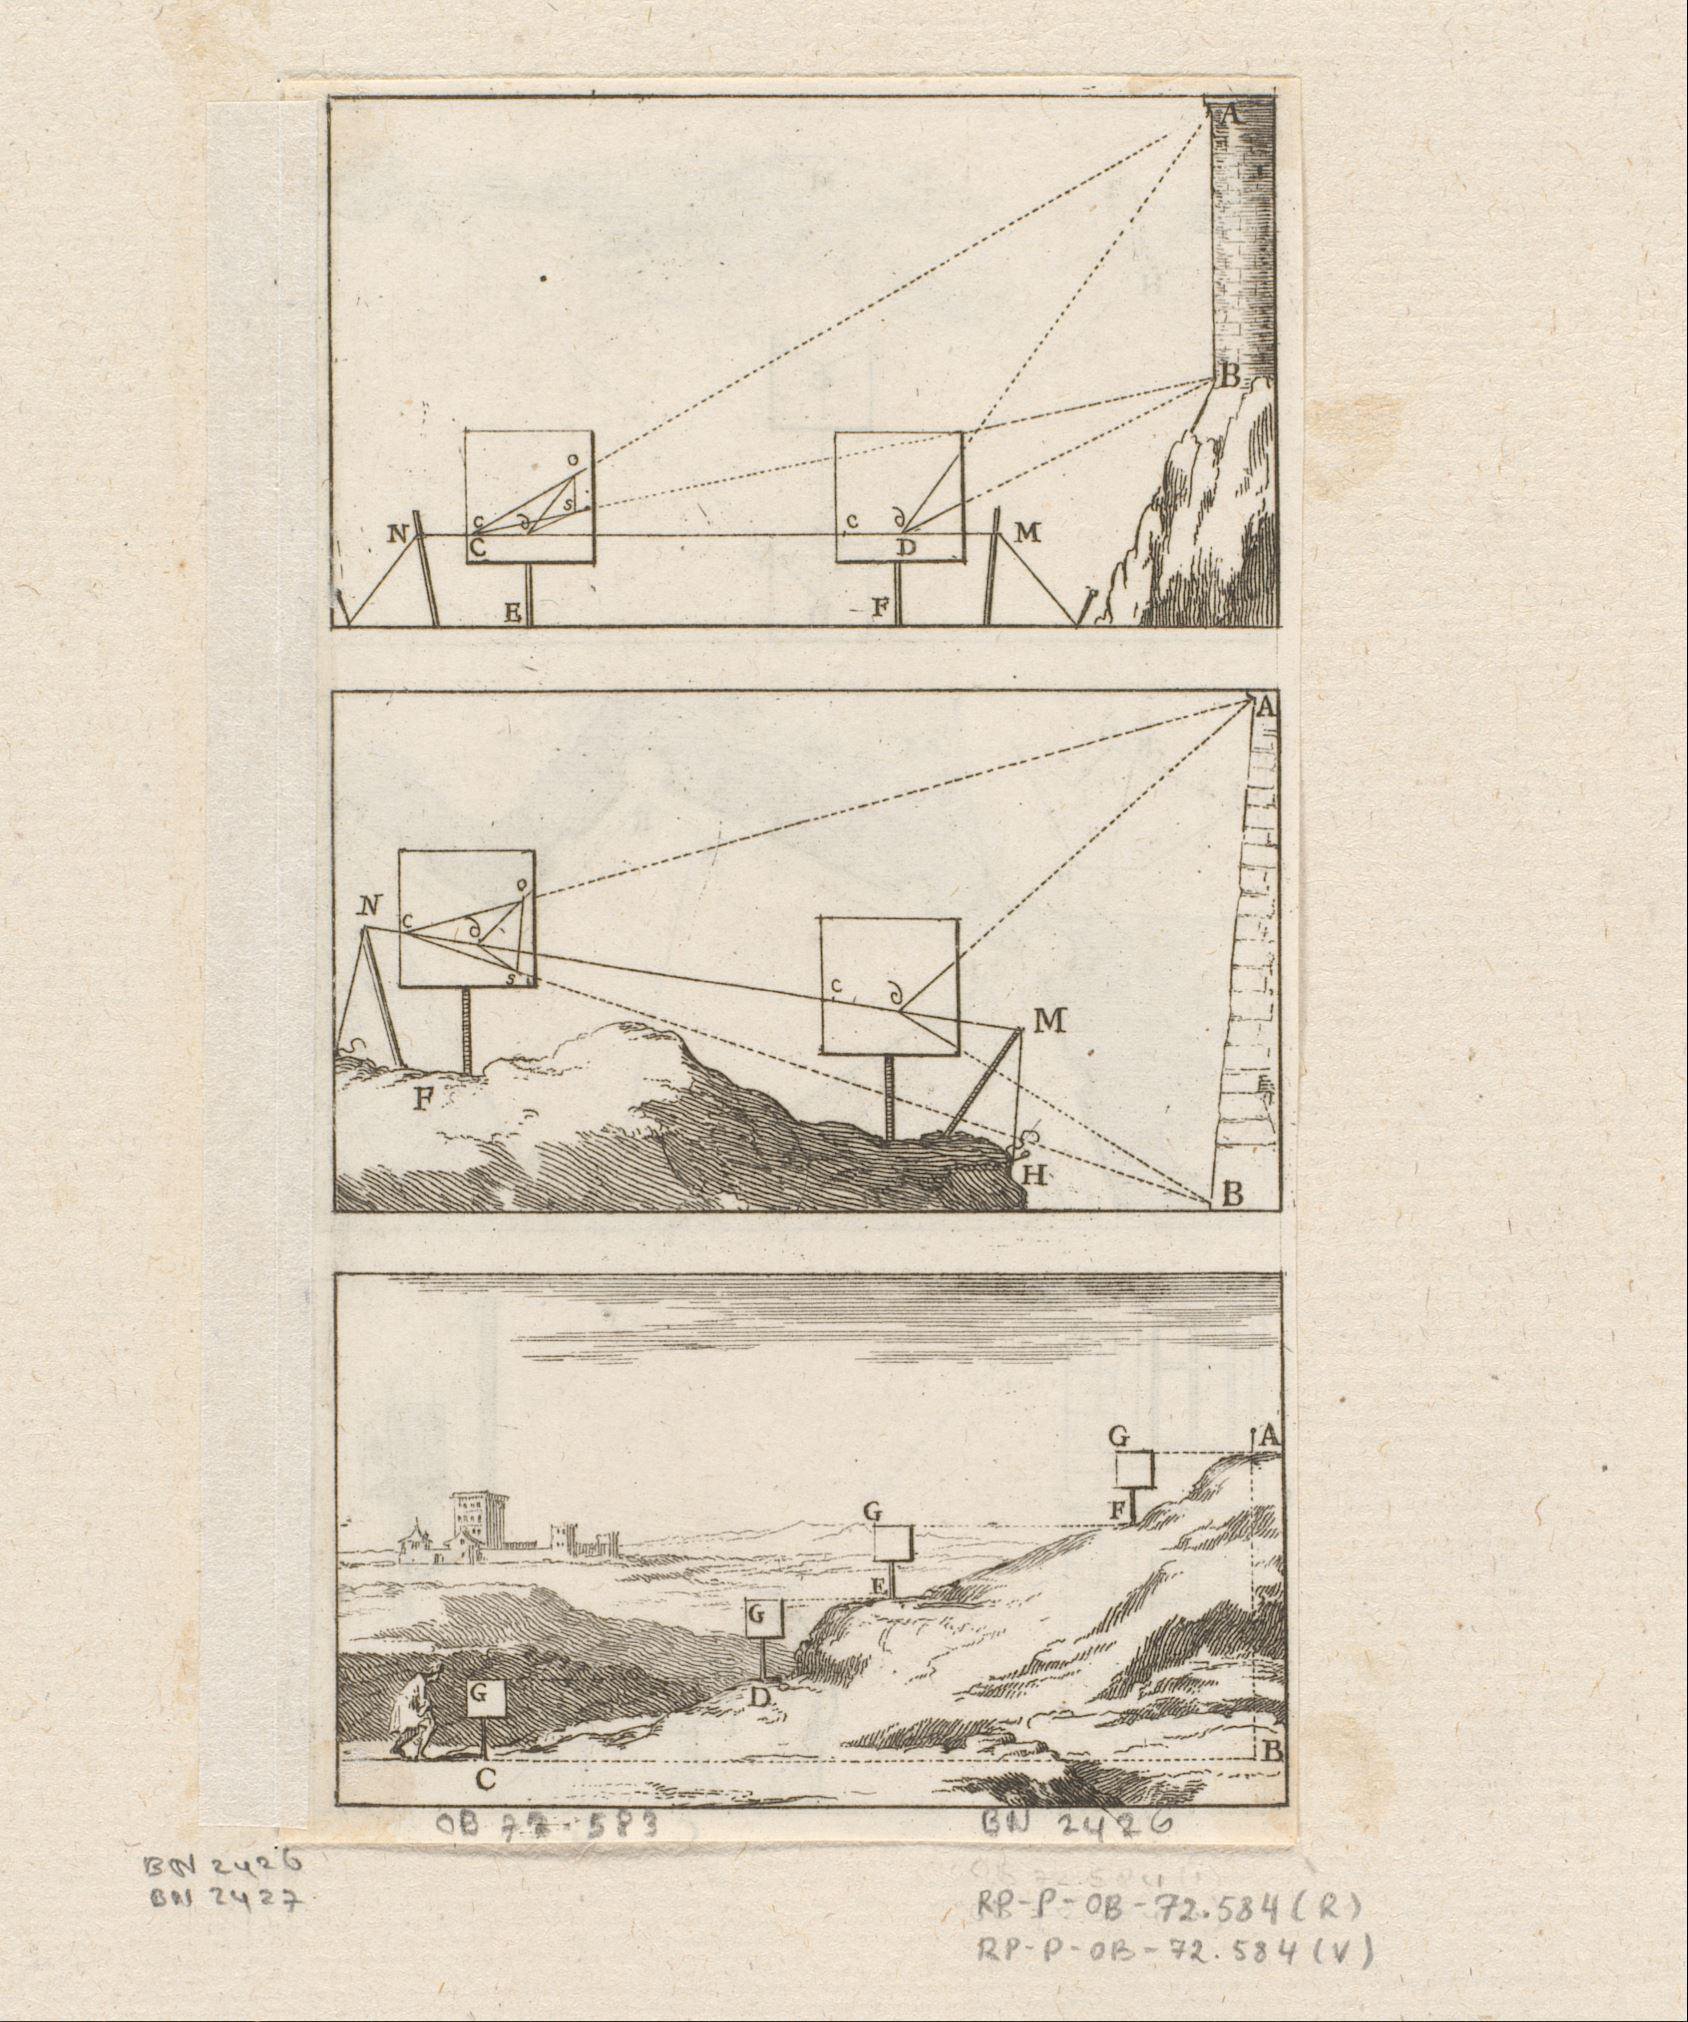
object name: print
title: Gebruik van een meetplank geïllustreerd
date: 1690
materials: paper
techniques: etching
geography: paris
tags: planimetry, geometry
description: Prent uit: Leclerc, Sébastien. Traité de géométrie (...). Parijs: Jean Jombert, 1690.